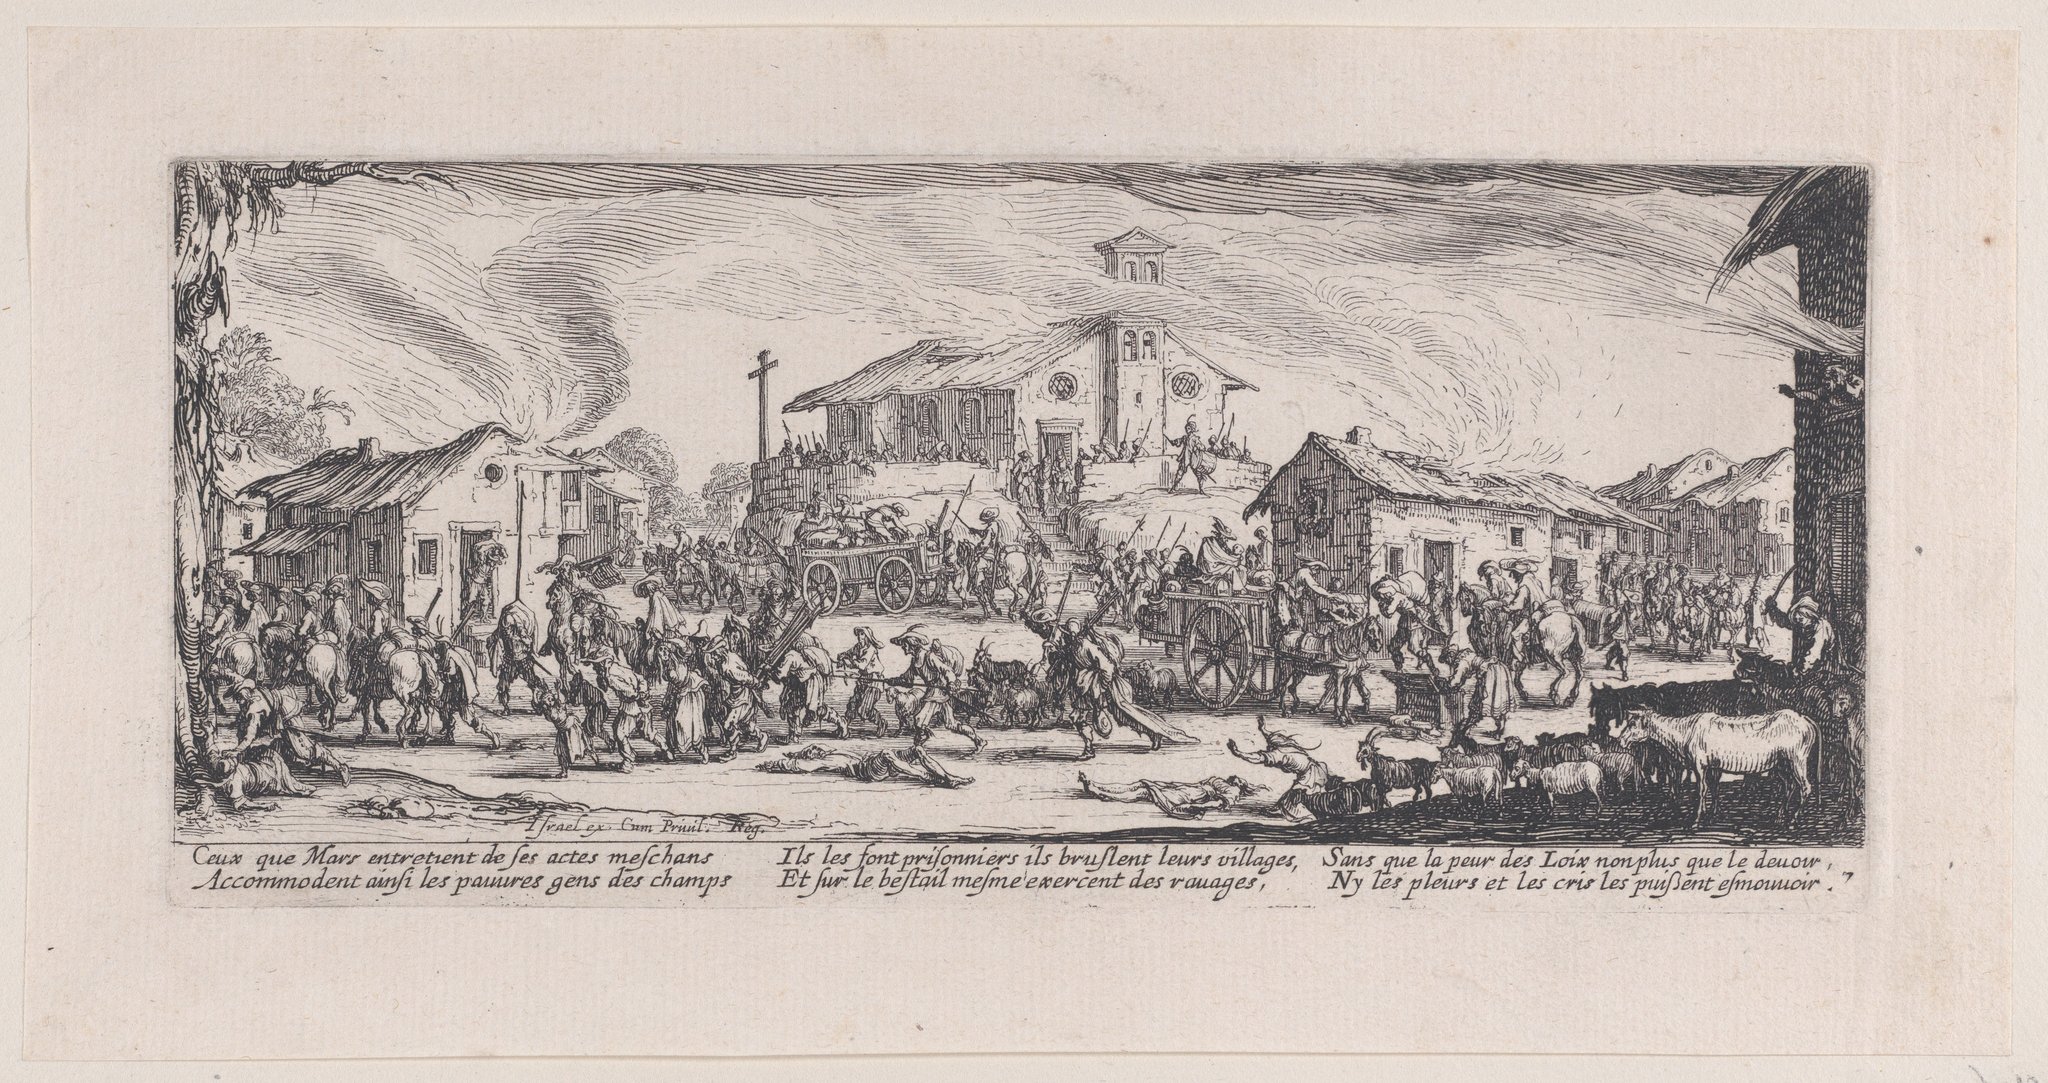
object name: print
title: Pillage et Incendie d'un Village (Looting and Burning of a Village), plate 7 from "Les Misères et les Mal-Heures de la Guerre" (The Miseries and Misfortunes of War)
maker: jacques callot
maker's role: artist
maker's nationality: french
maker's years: 1592-1635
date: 1633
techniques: etching